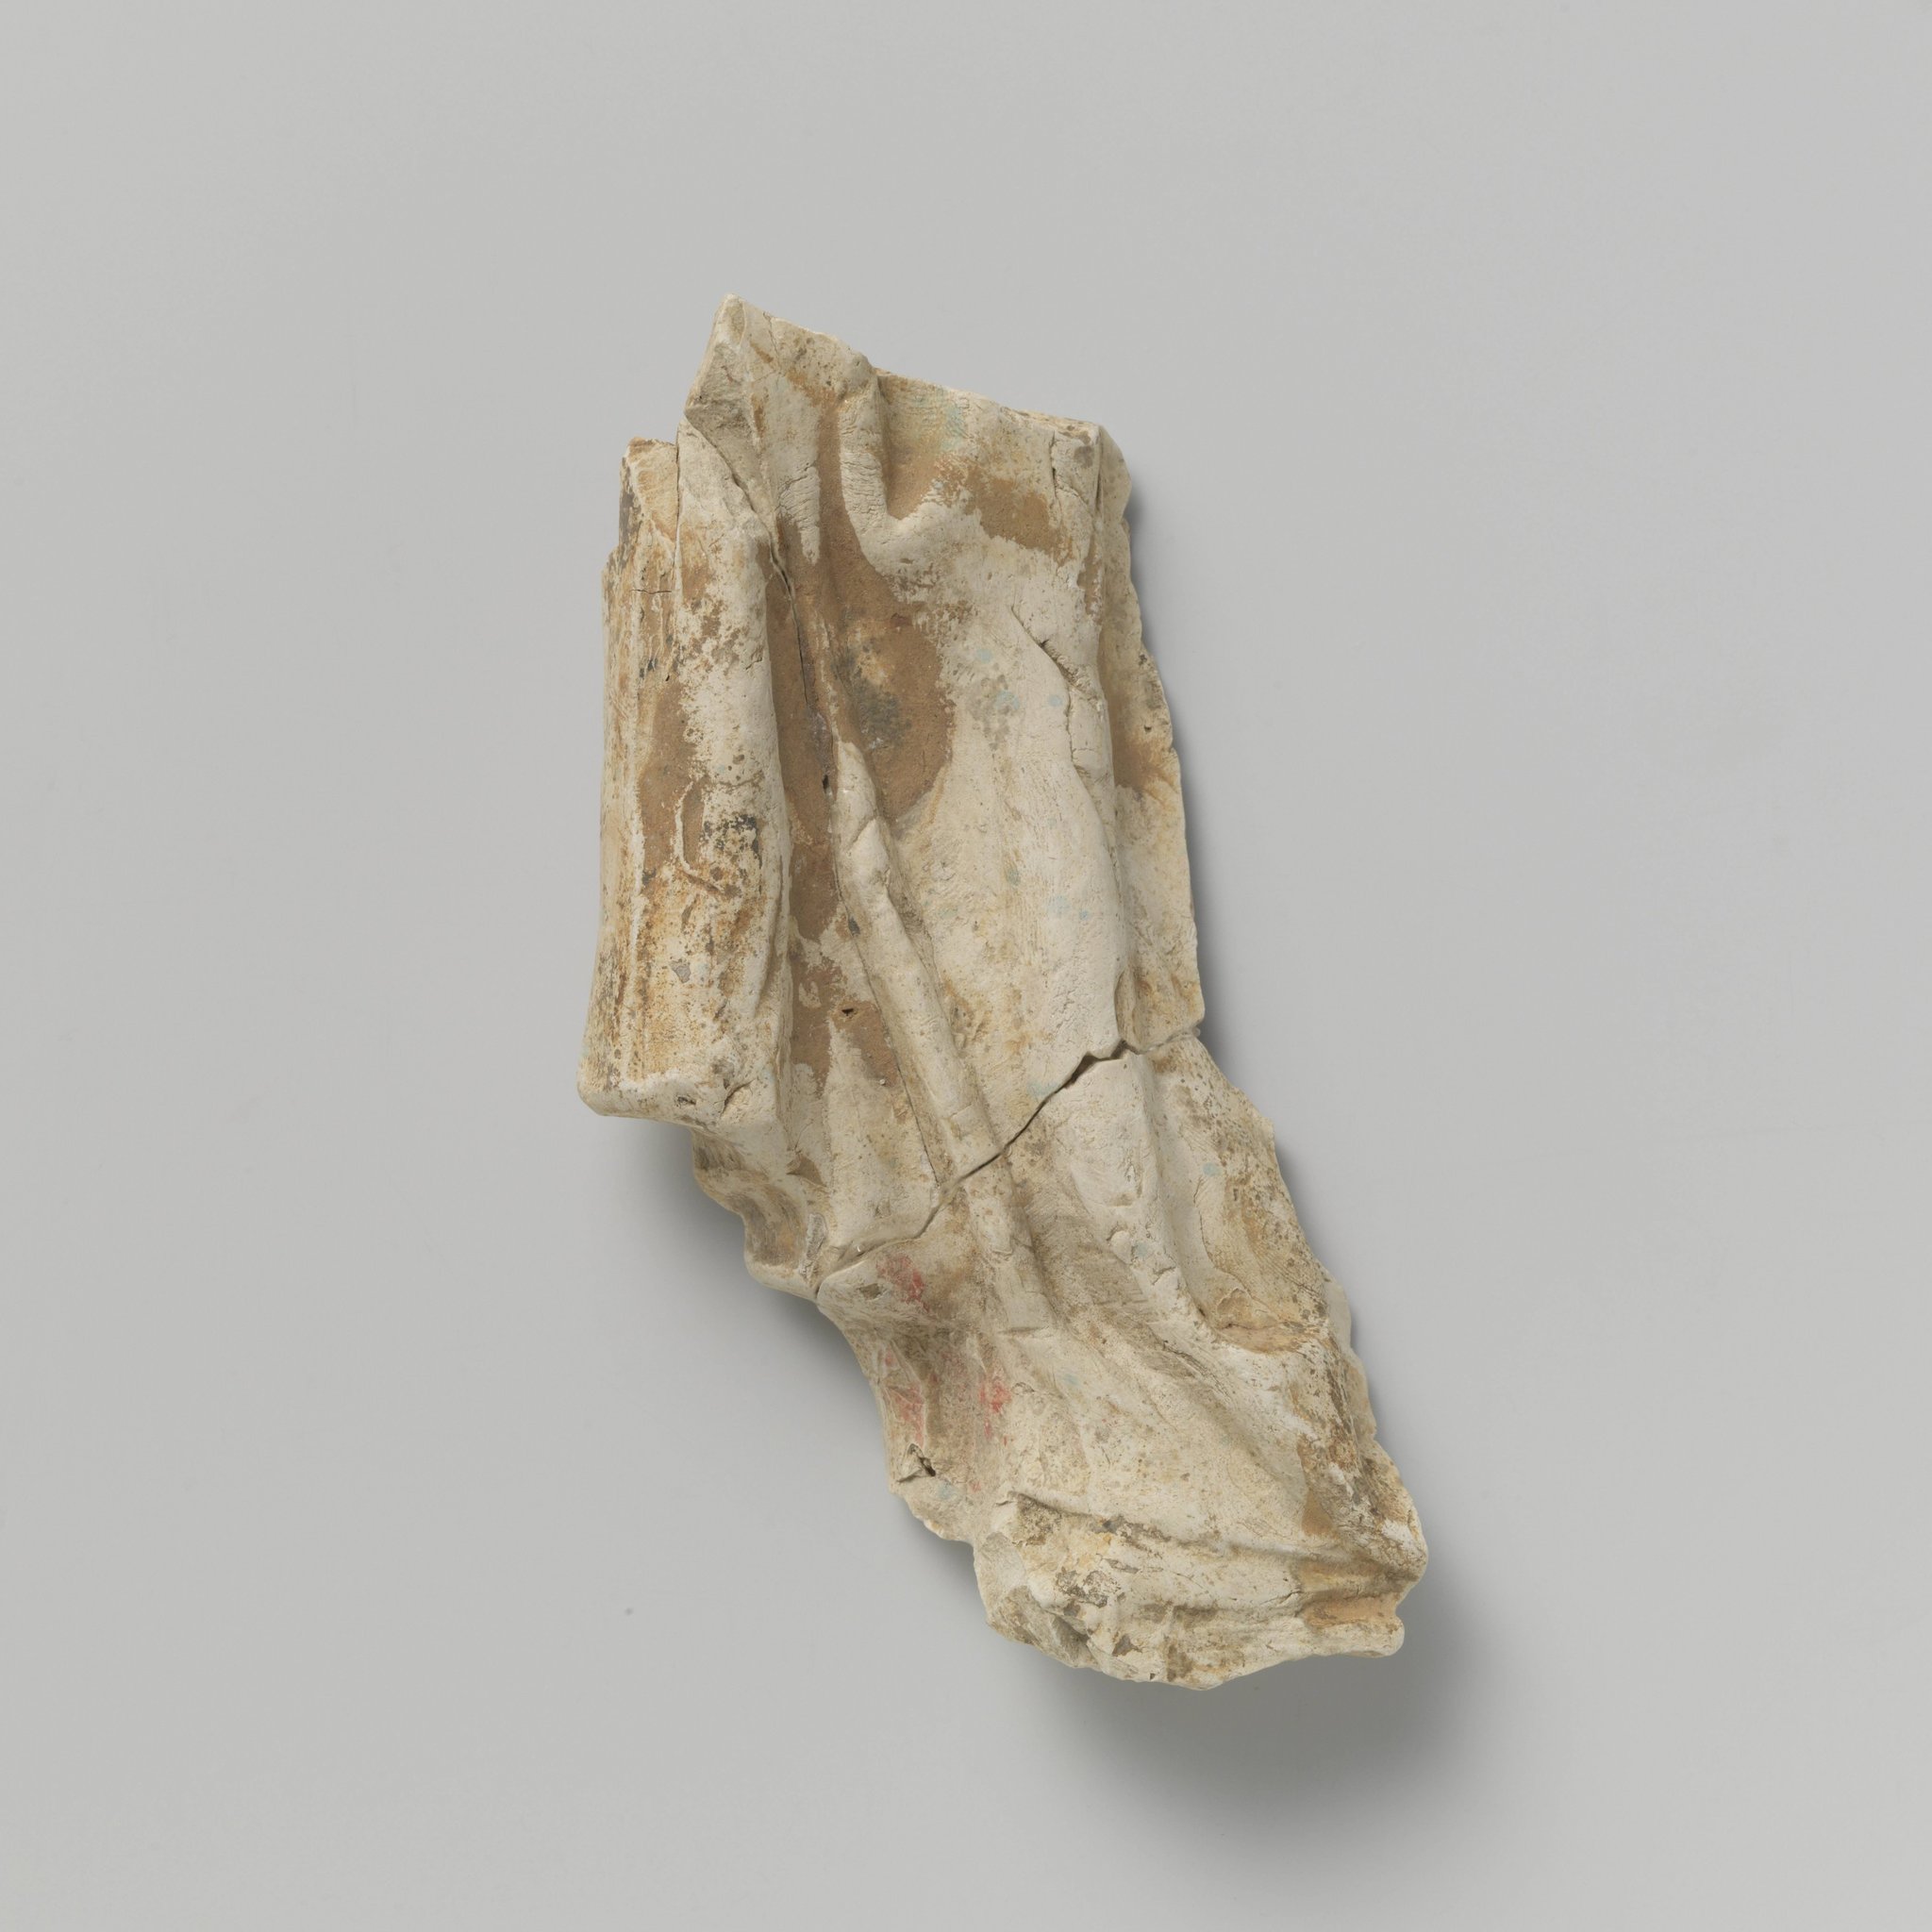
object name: sculpture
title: Figurine, Fragment of the Garment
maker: Anonymous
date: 1425-1550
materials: clay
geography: northern netherlands